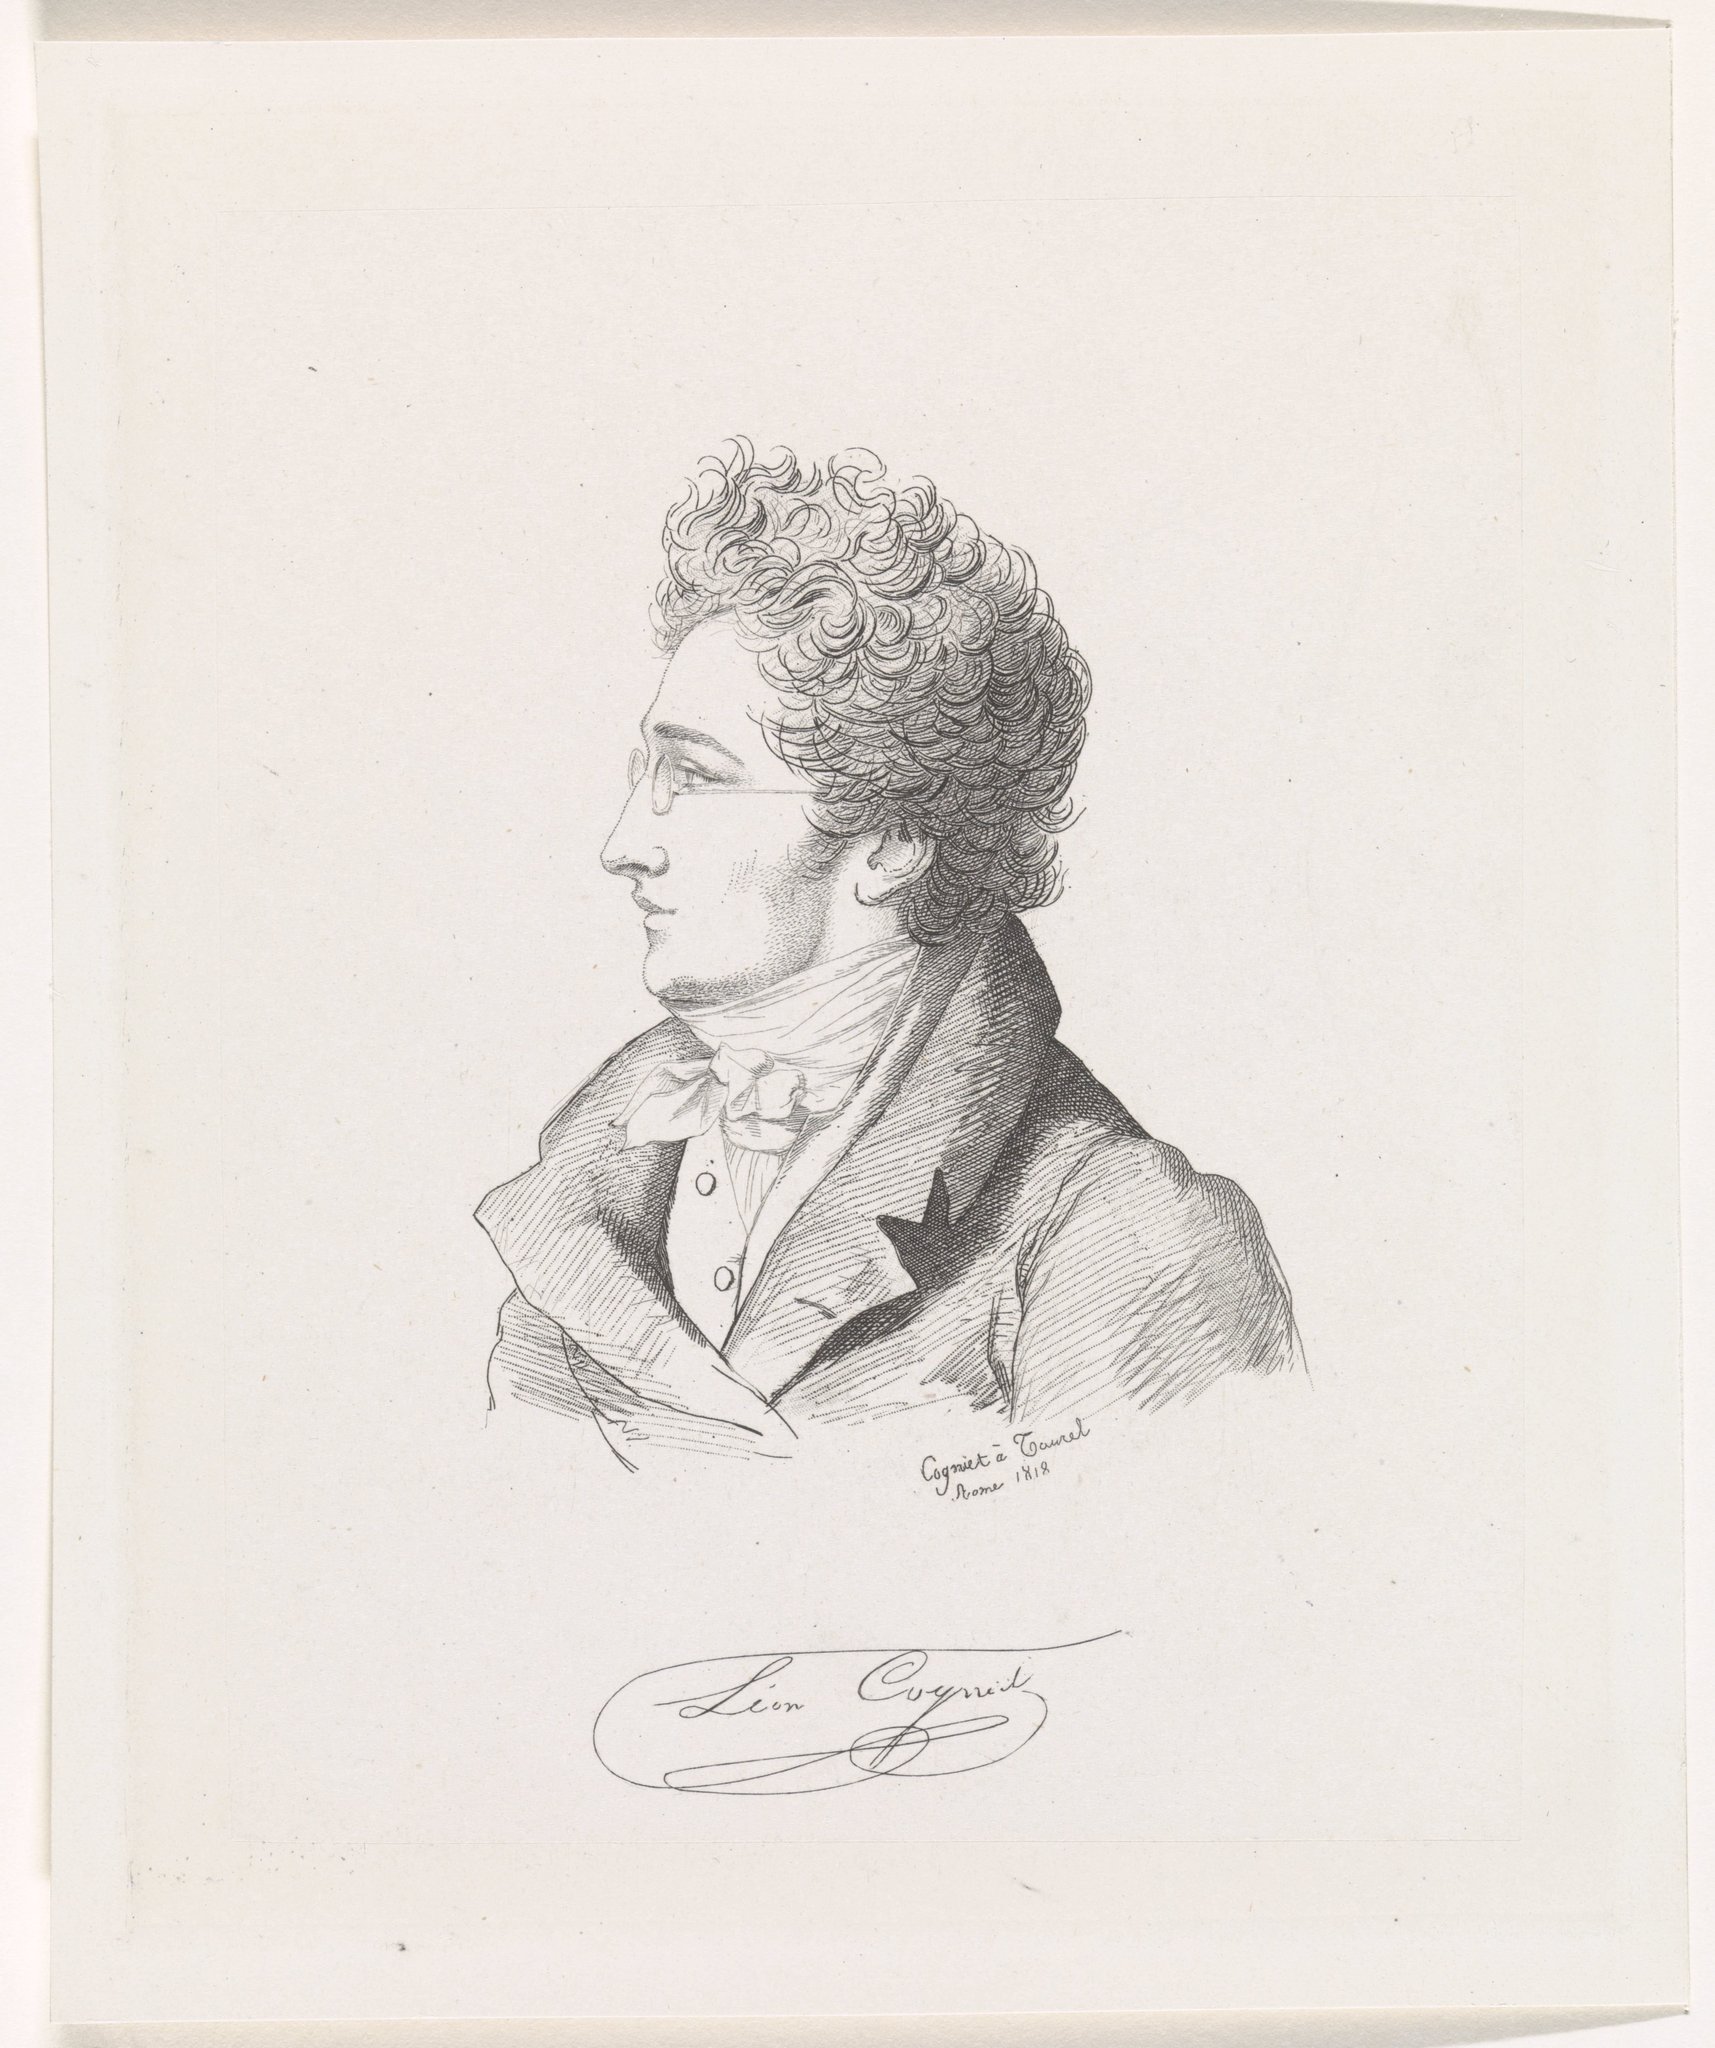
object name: print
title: Portret van de kunstenaar Léon Cogniet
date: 1818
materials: paper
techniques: etching, roulette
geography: amsterdam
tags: paris, painter, léon cogniet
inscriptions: collector's mark: Lugt 2228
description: Prent ook gebruikt als illustratie in: L'album T. douze eaux-fortes d'après des dessins originaux et inédits de Jean Alaux, Léon Cogniet, Coutan, Henriquel Dupont, Ingres, Léopold Robert et Etna Michalon avec texte explicatif et biographique enrichi de lettres inédites. Amsterdam en Den Haag: 1885.